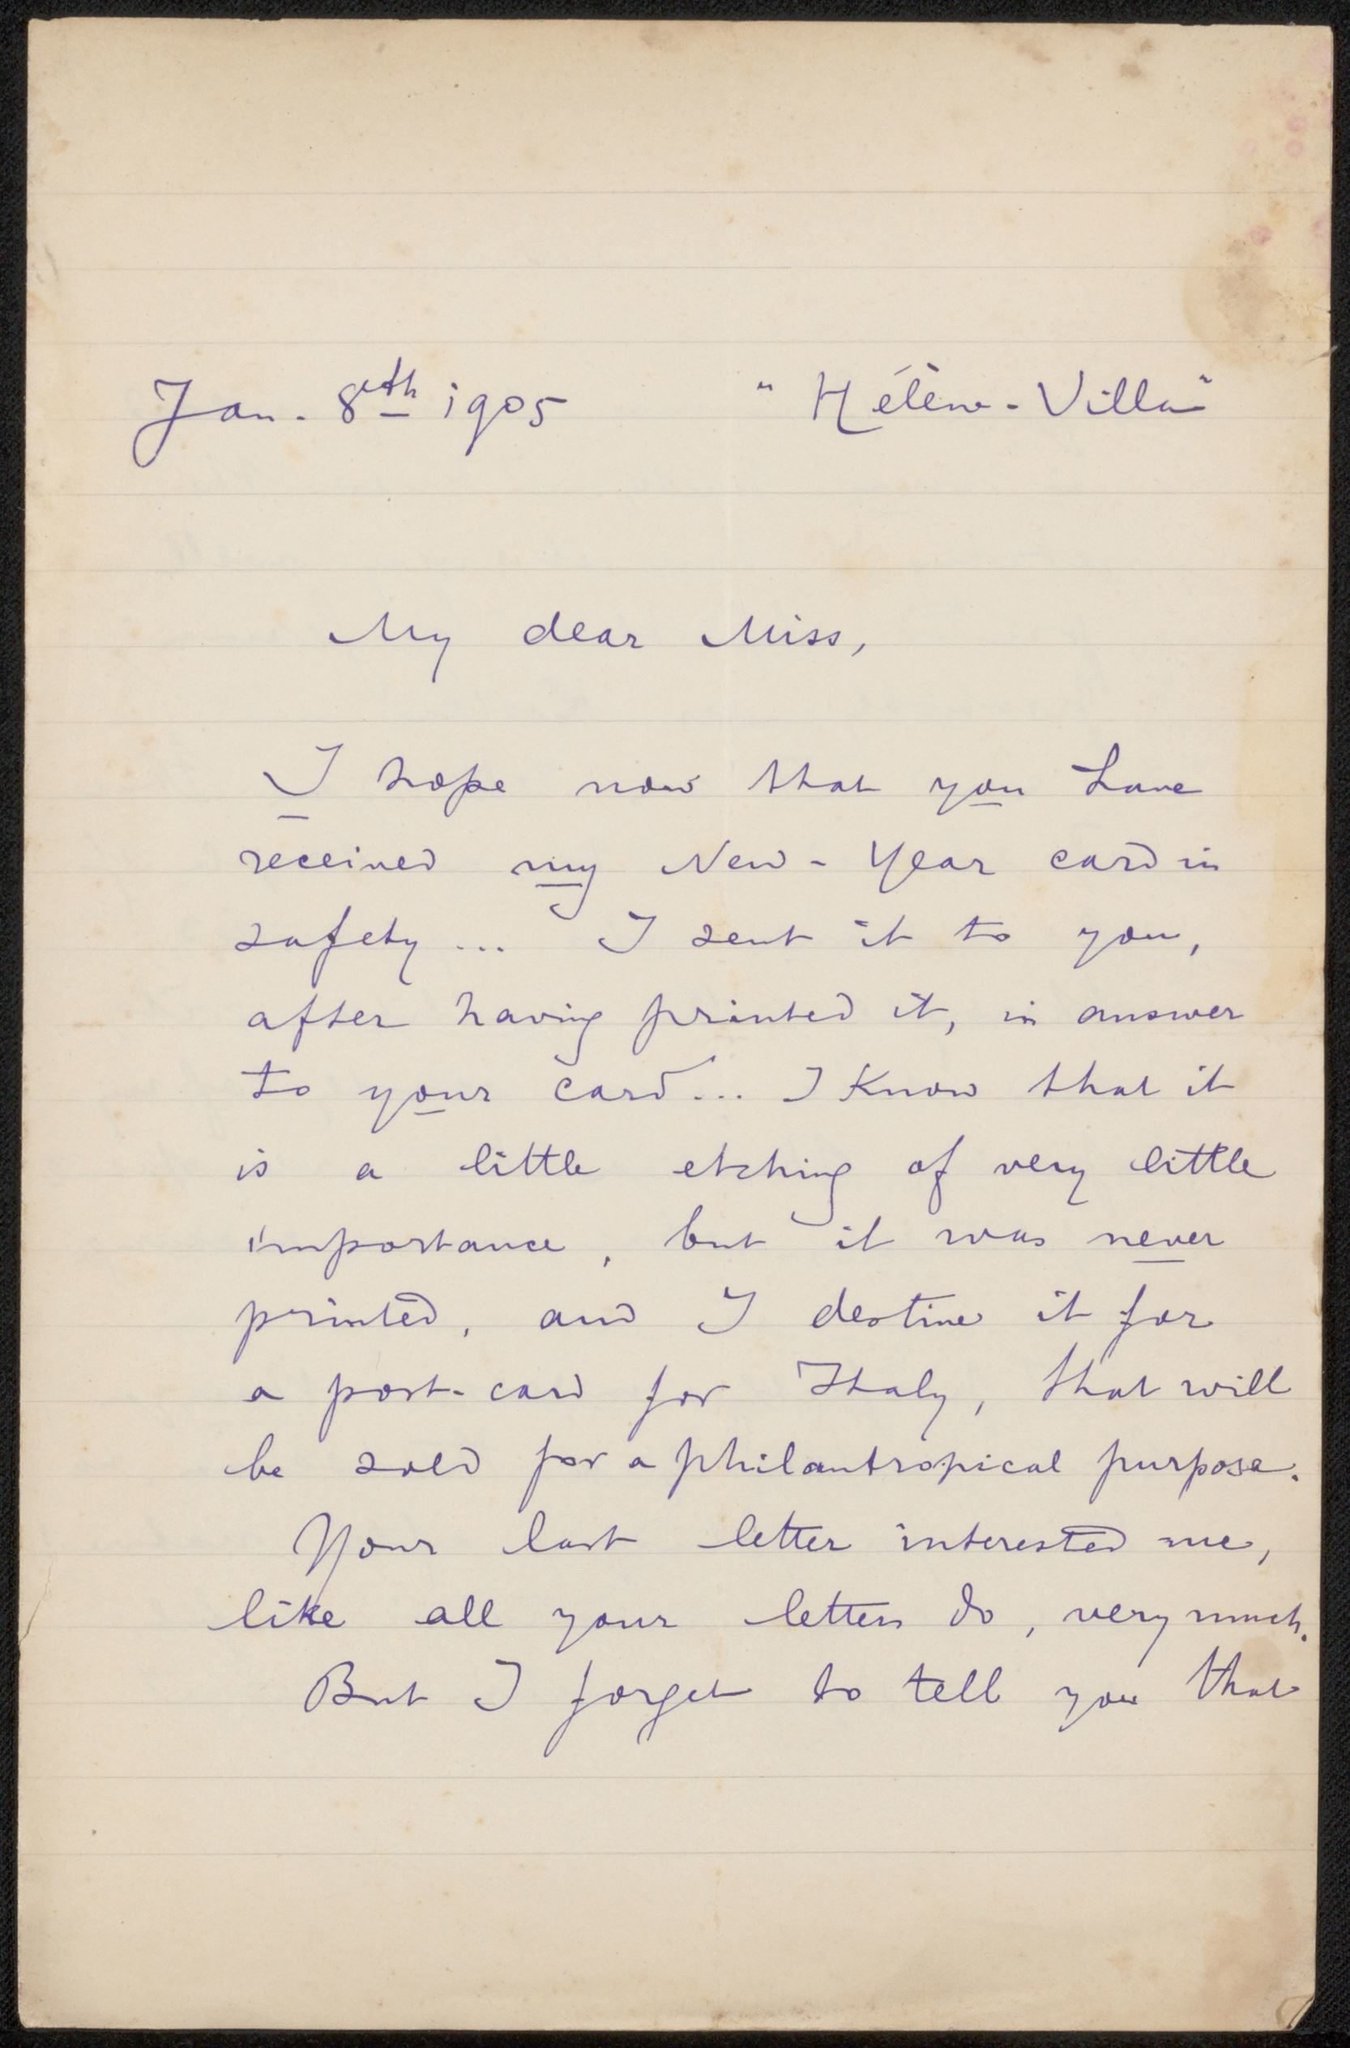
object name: letter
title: Brief aan Elsie Maud Cownie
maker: philip zilcken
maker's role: draughtsman, painter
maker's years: 1857-1930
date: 1905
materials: ink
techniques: pen, writing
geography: the hague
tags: liverpool, walter crane, manchester, elsie maud cownie, drawing, the graphic arts, printed matter, venice